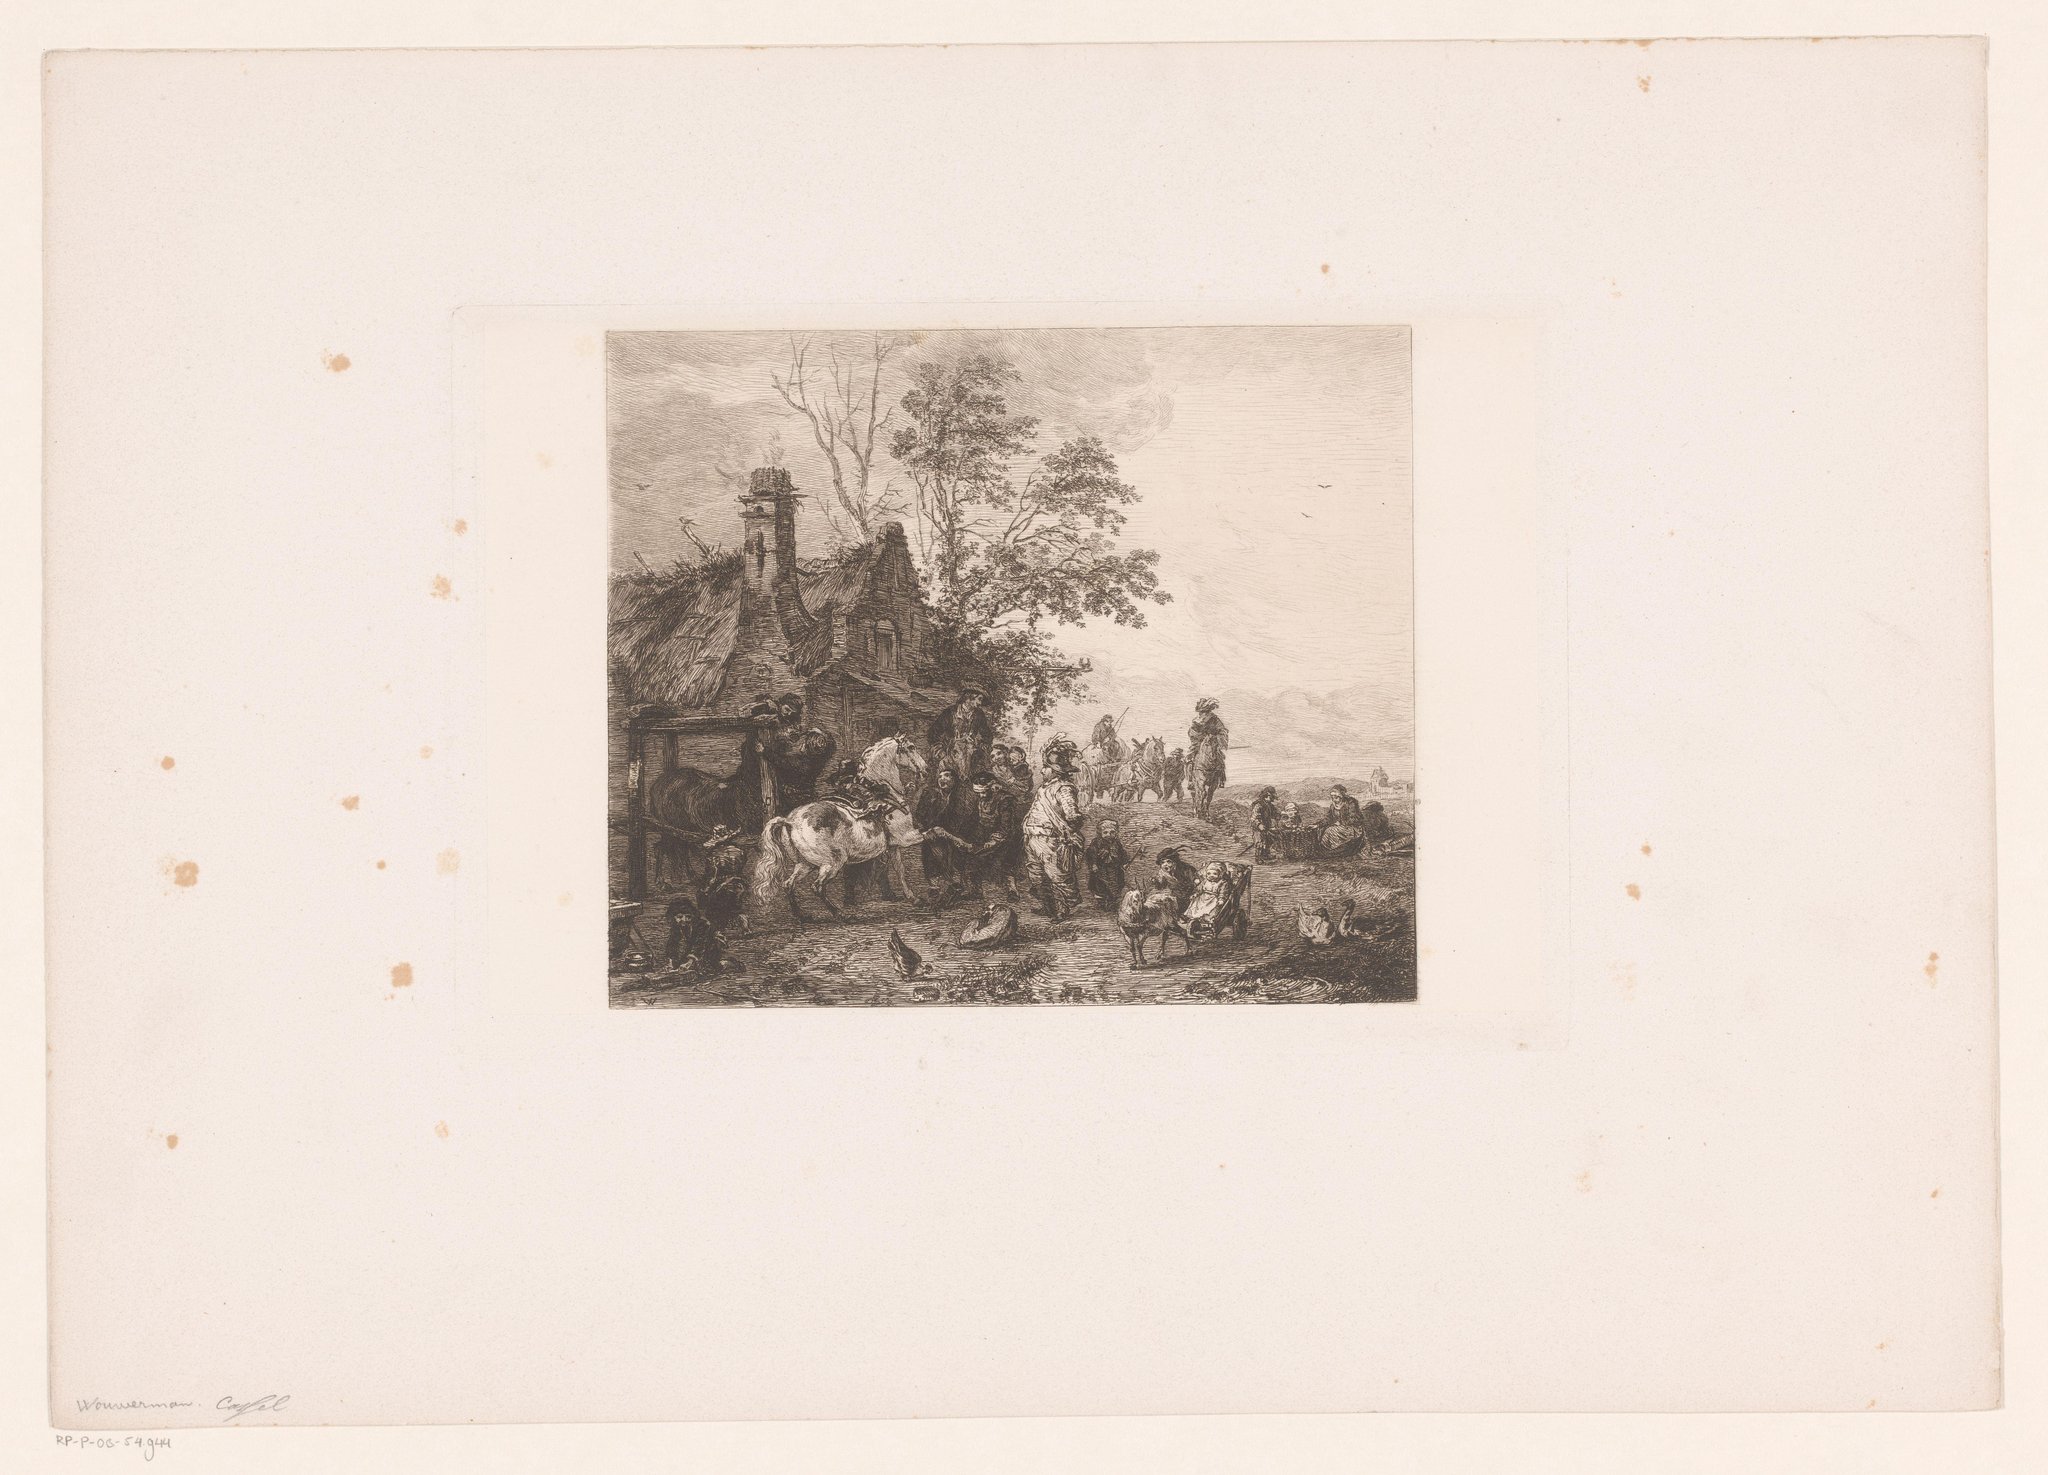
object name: print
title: Gezelschap met paarden bij een smederij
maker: william unger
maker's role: draughtsman, painter, print maker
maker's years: 1837-1932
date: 1847-1889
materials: paper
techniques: etching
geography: germany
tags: horse, smith, blacksmith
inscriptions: collector's mark: Lugt 2228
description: Prent naar het schilderij door Philips Wouwerman in de Gemäldegalerie Alte Meister te Kassel (inv.nr. GK 362).